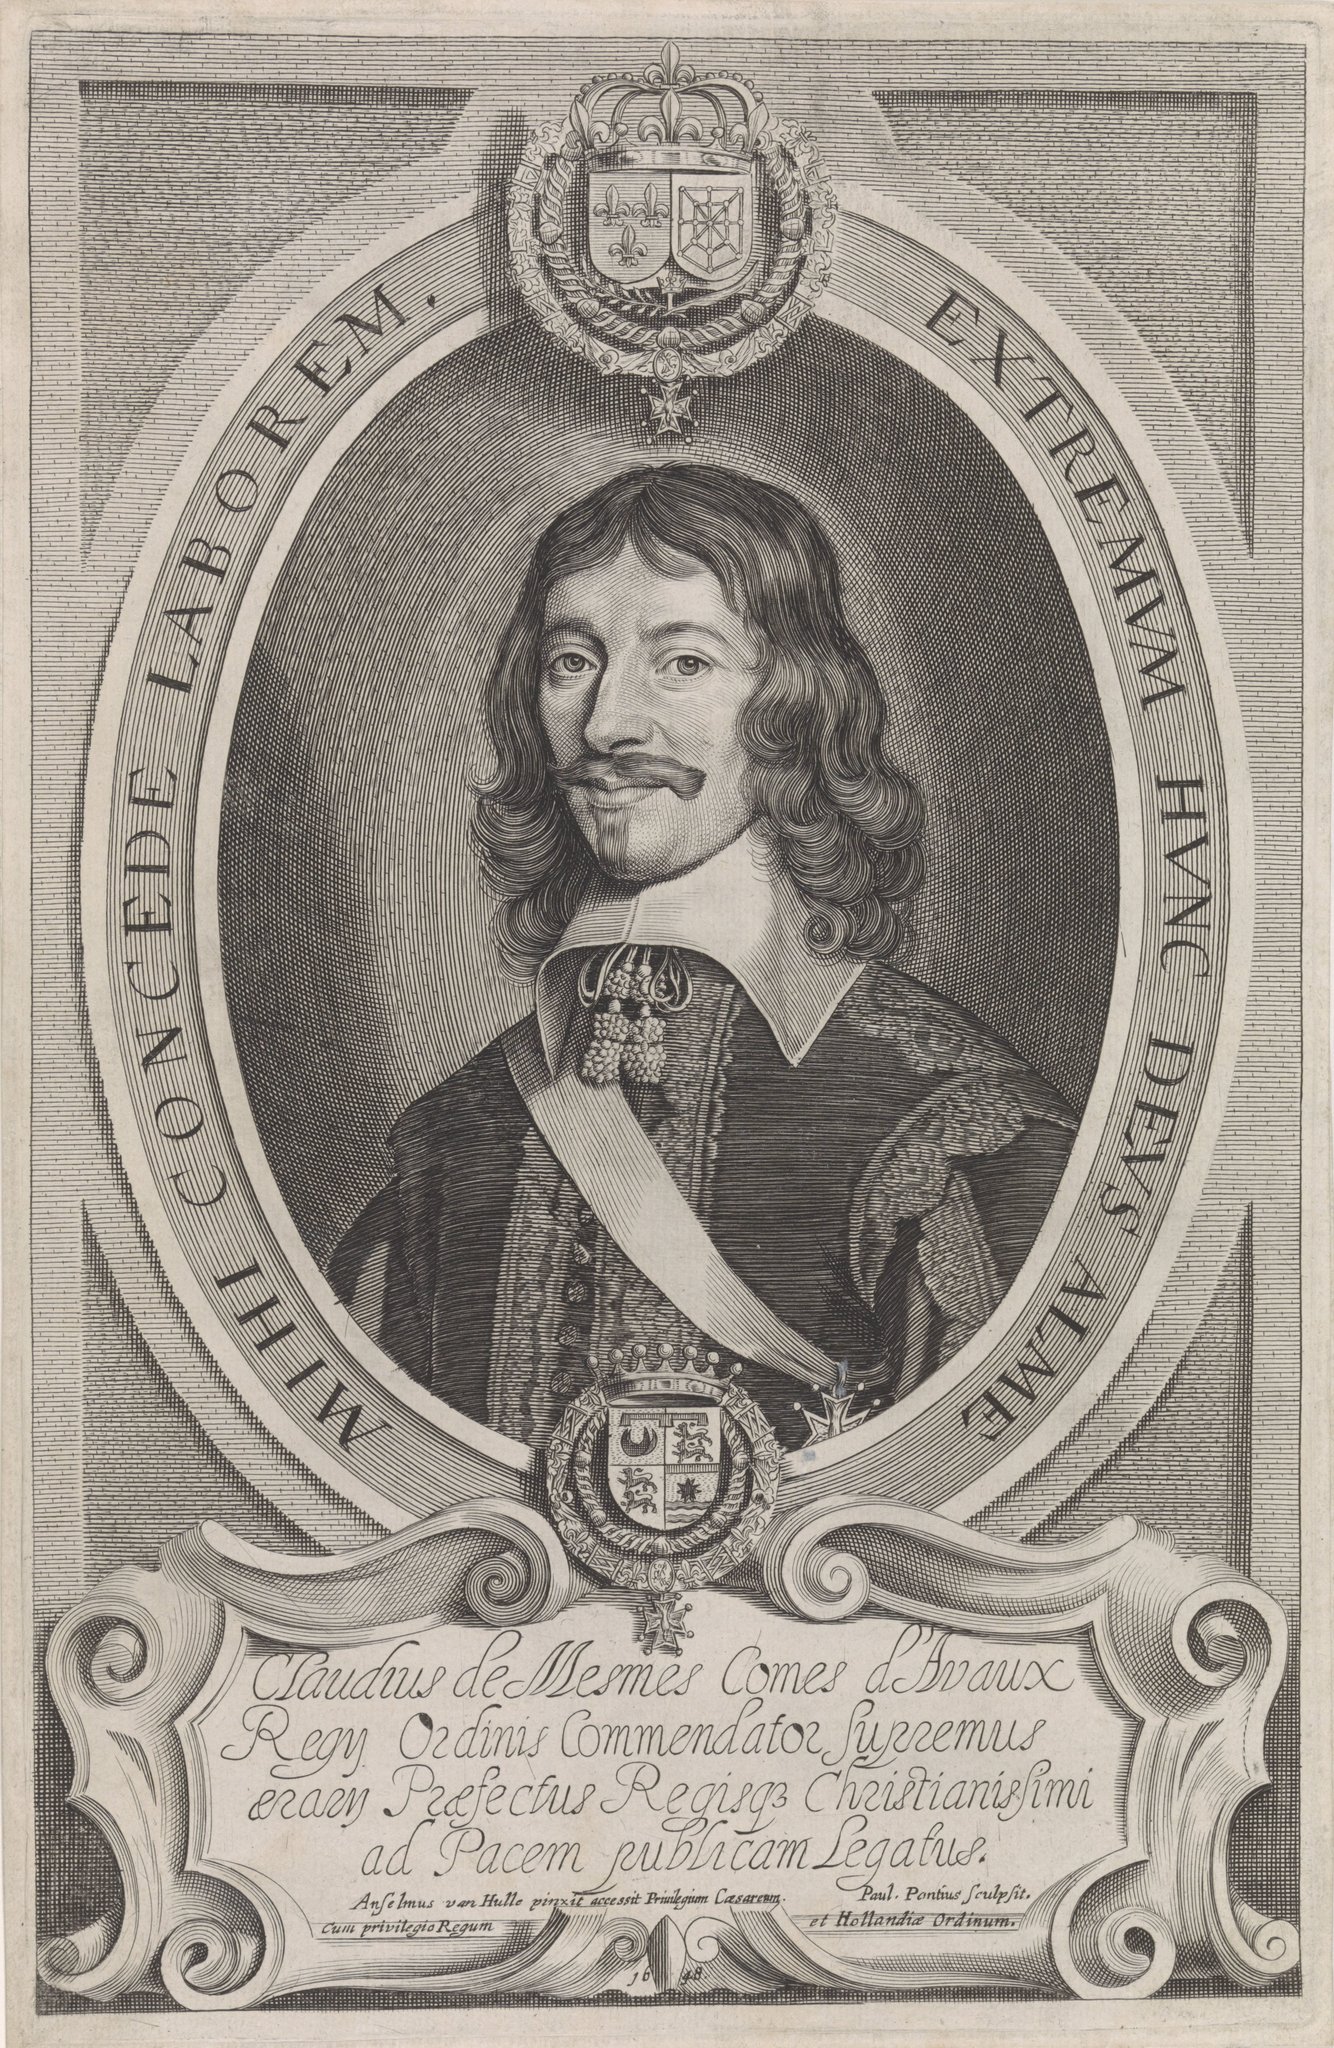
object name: print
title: Portret van Claudius de Mesmes, graaf d'Avaux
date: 1648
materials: paper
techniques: engraving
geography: antwerp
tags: knighthood order of the holy spirit, armorial bearing, heraldry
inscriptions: collector's mark: Lugt 2760, collector's mark: Lugt 2228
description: Prent ook opgenomen in: Pacificatores orbis christiani, sive Icones principum, ducum et legatorum, qui Monasterii atque Osnabrugæ pacem Europæ reconciliarunt (...). = Pronkbeelden der vorsten, en vredehandelaars. Rotterdam: Pieter van der Slaart, 1697.